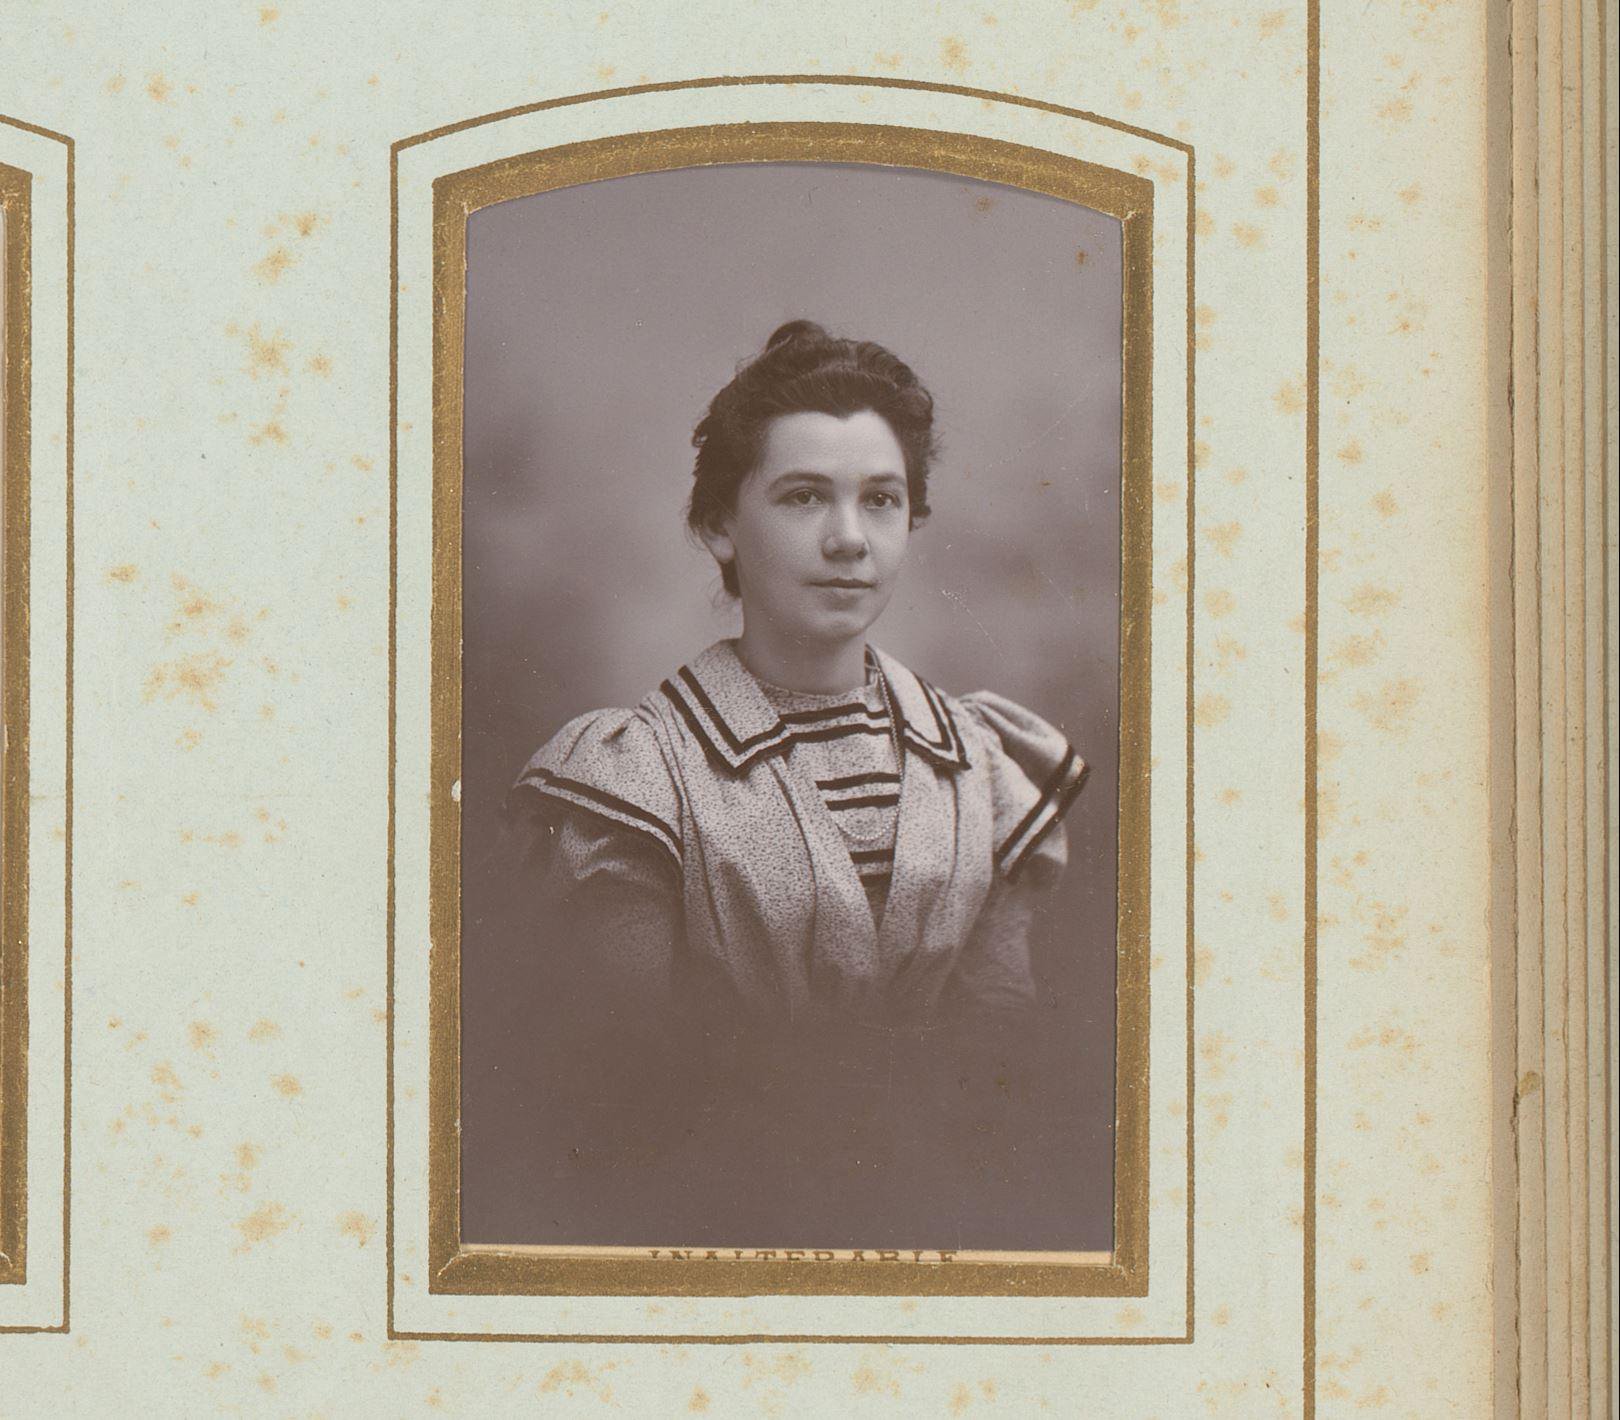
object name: photograph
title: Portret van een jonge vrouw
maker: Anonymous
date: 1880-1920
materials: cardboard, photographic support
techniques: collodion silver print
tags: adolescent, young woman, maiden, historical persons - bb - woman